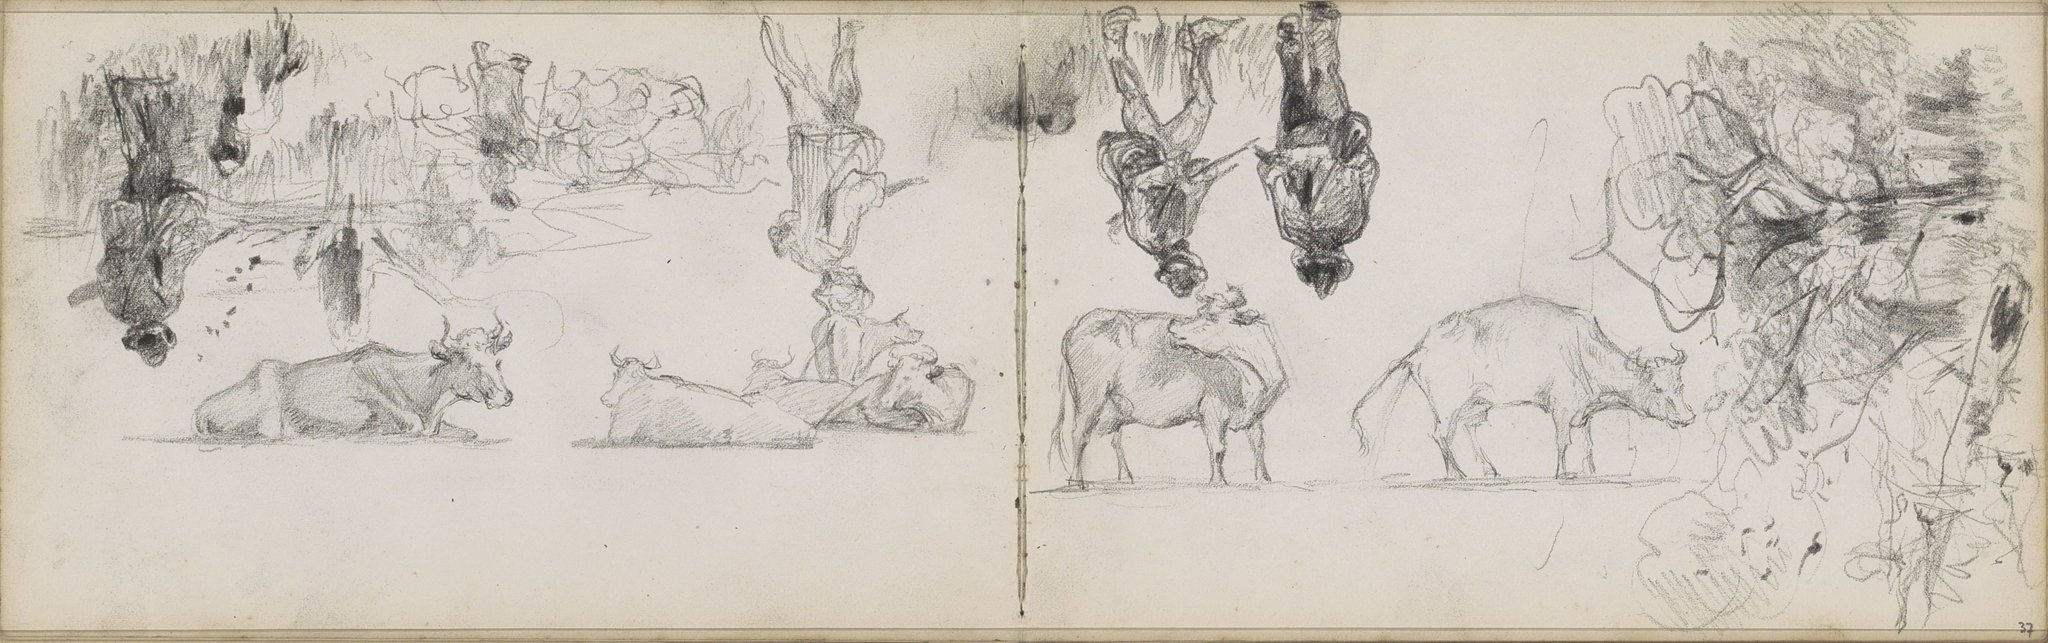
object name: sketchbook leaf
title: Studieblad met jagers, een herder, bomen en koeien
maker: willem cornelis rip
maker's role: draughtsman, painter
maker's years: 1856-1922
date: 1874-1875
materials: paper, pencil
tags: trees, cow, herding, herdsman, herdswoman, shepherd, shepherdess, cowherd, etc., hunter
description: Blad 36 verso en 37 recto uit een schetsboek met 46 bladen.